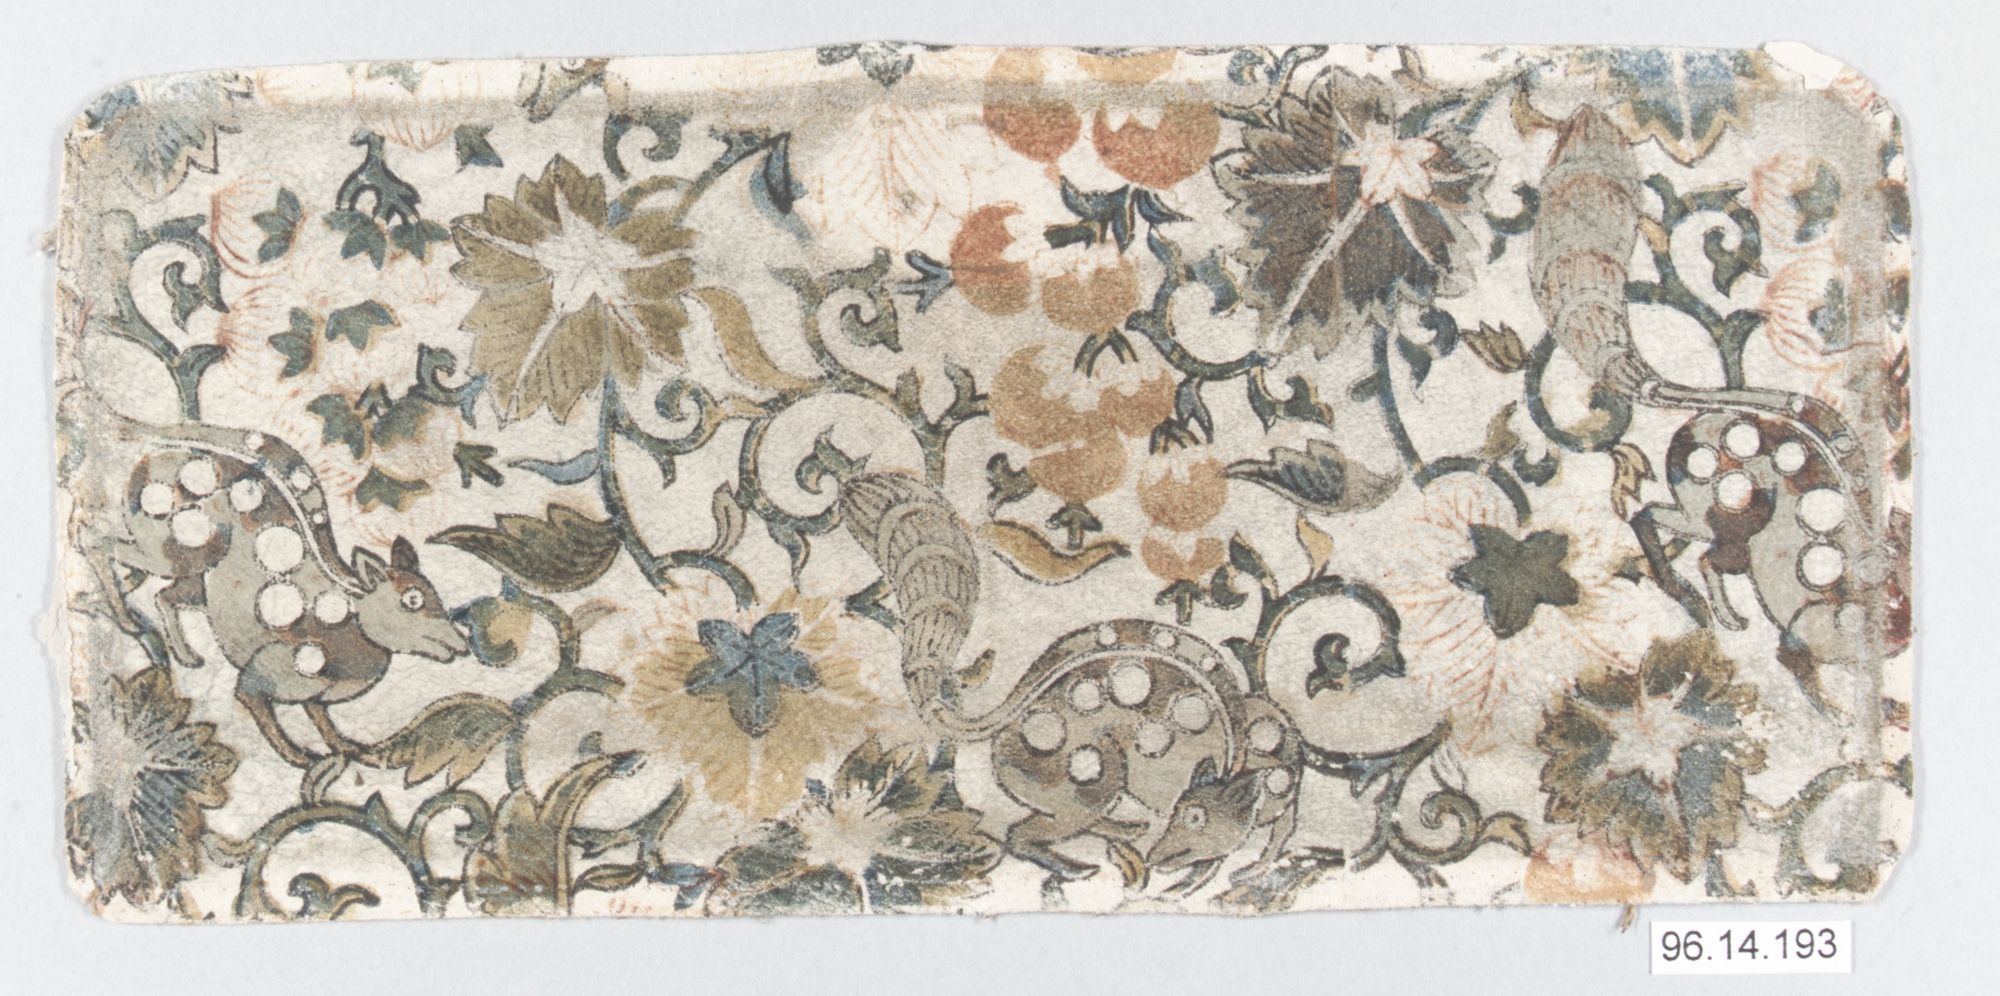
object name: piece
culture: japanese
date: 1701-1900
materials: leather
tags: animals,leaves